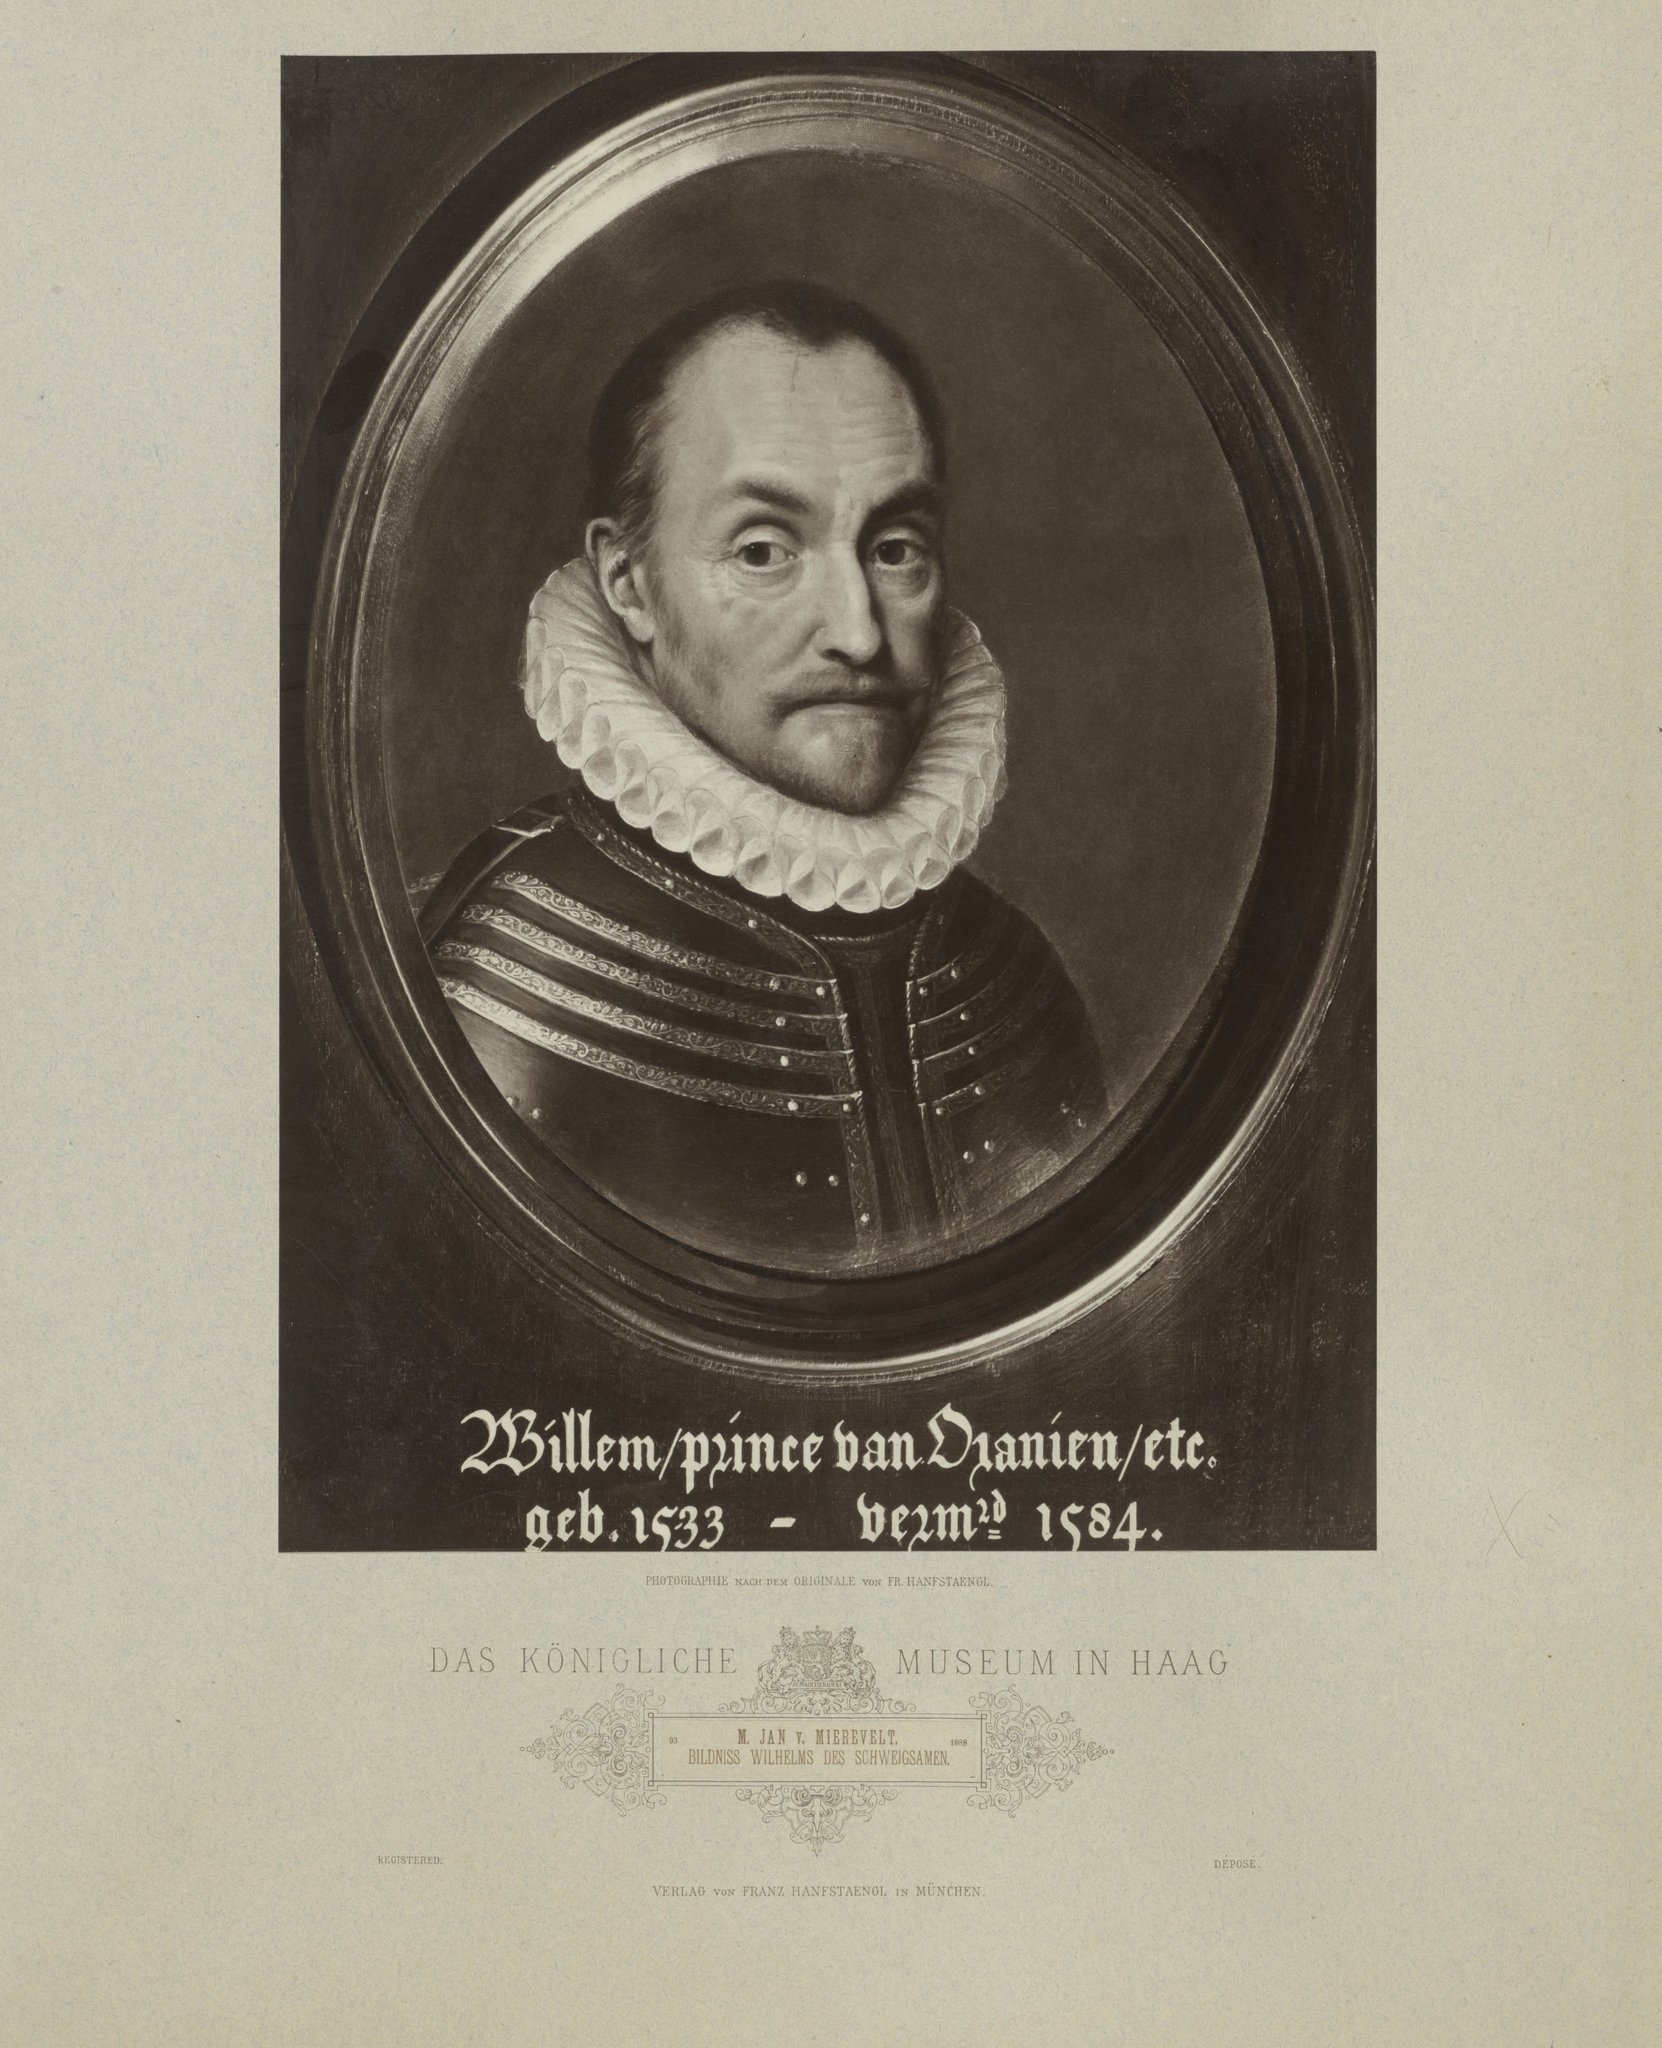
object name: photograph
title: Portret van Willem I, prins van Oranje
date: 1852-1877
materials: cardboard, photographic support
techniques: photography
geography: munich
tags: delft, william i (prince of orange)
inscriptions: octrooivermelding, gedrukt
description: De hier vermelde titel verwijst naar de hoogst verkregen titel van de geportretteerde, niet per se naar de titel die de geportretteerde op deze voorstelling draagt.